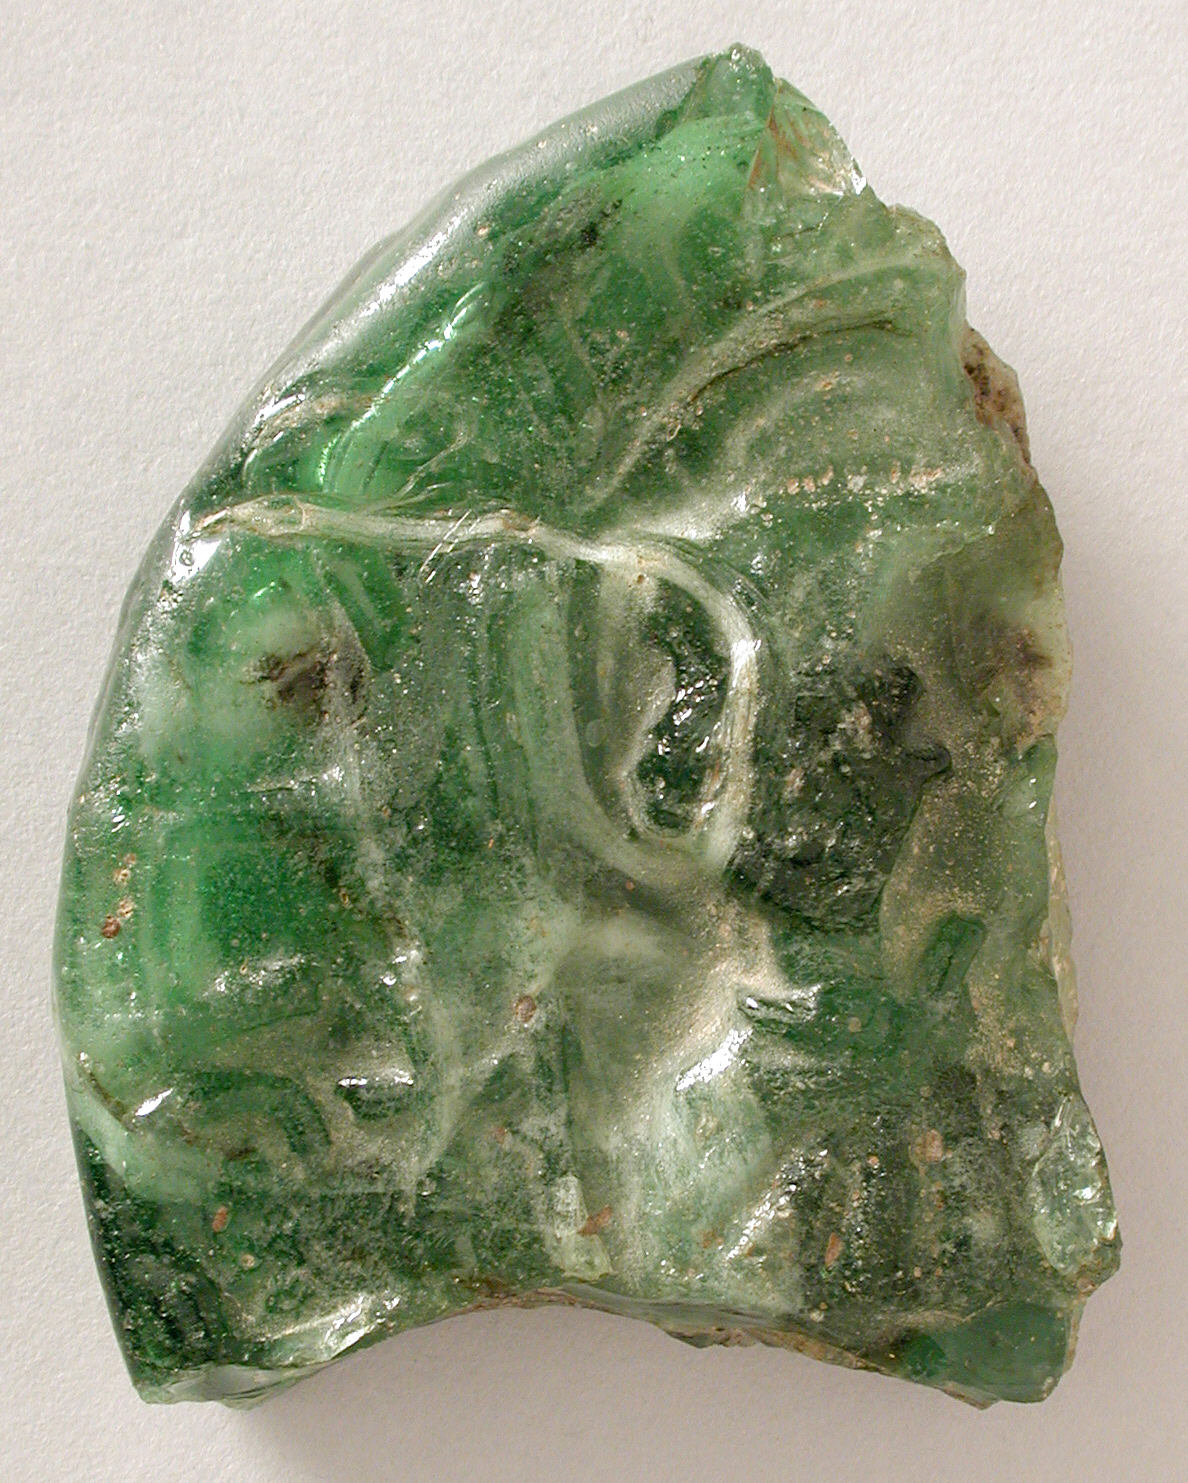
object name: fragment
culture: byzantine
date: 501-700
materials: glass